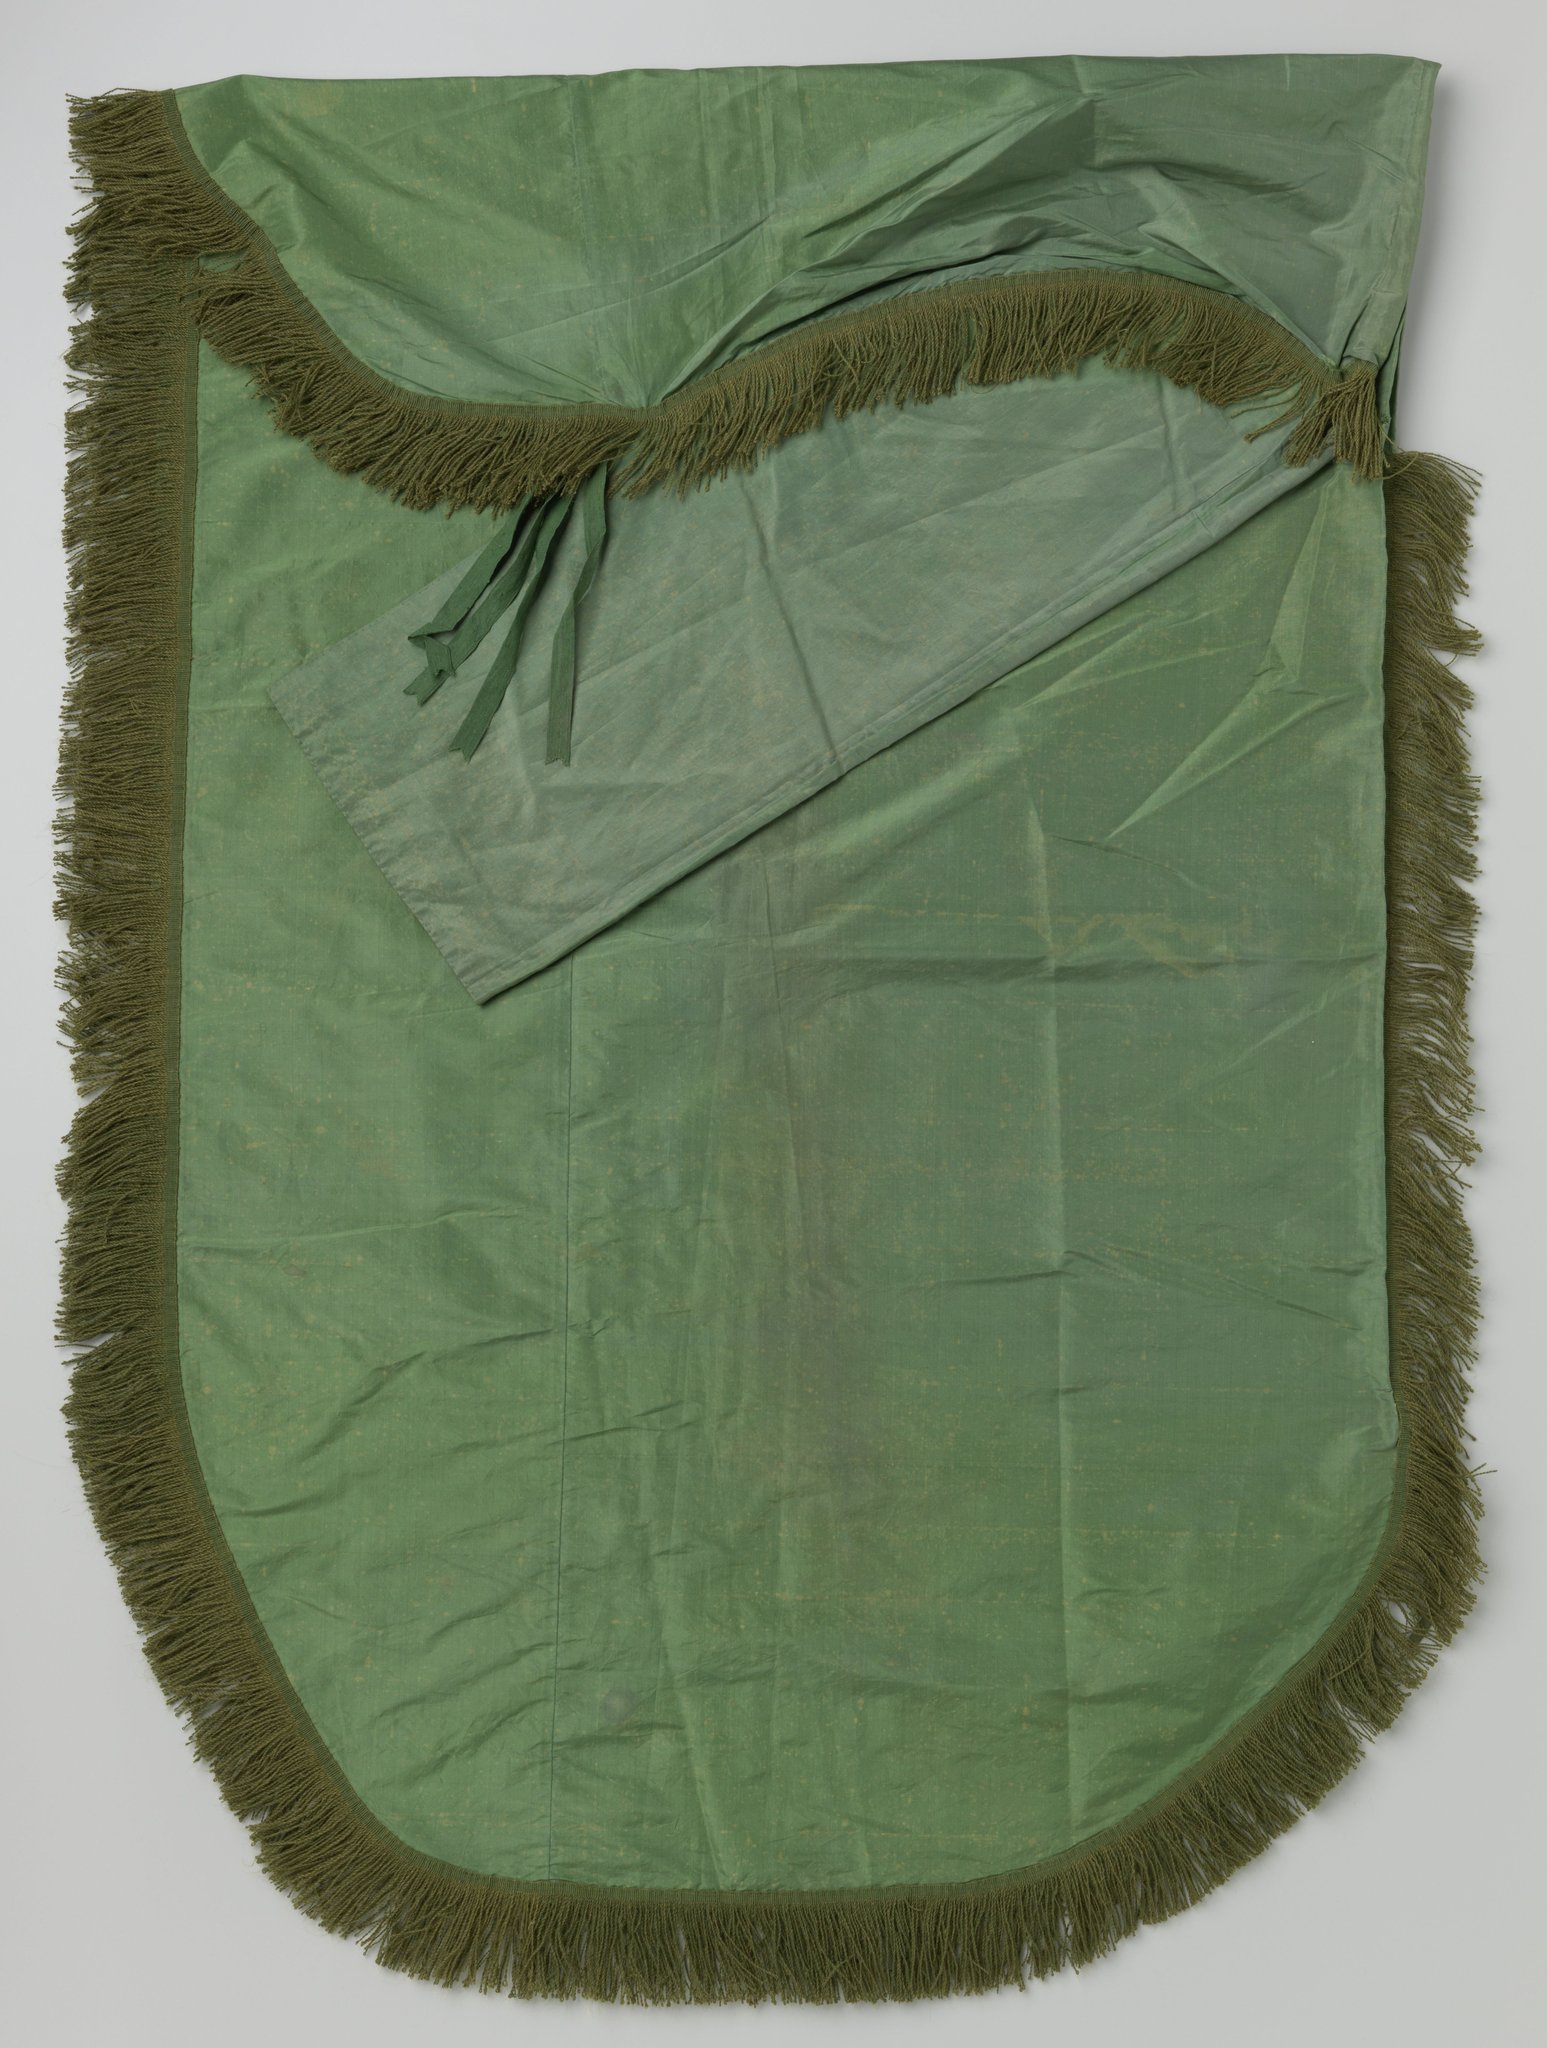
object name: dekkleed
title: Groen zijden afdekkleed met wollen franje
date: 1700-1799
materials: linen, silk, wool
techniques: weave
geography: netherlands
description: Twee afdekkleden (a,b), het tweede (b) wellicht voor een vuurmand, van groene zijde met groen wollen franje, met een bijbehorende strook groene zijde met knoopsgaten en een vastgenaaide wit linnen strook (c) en een strook groene wollen franje (d).